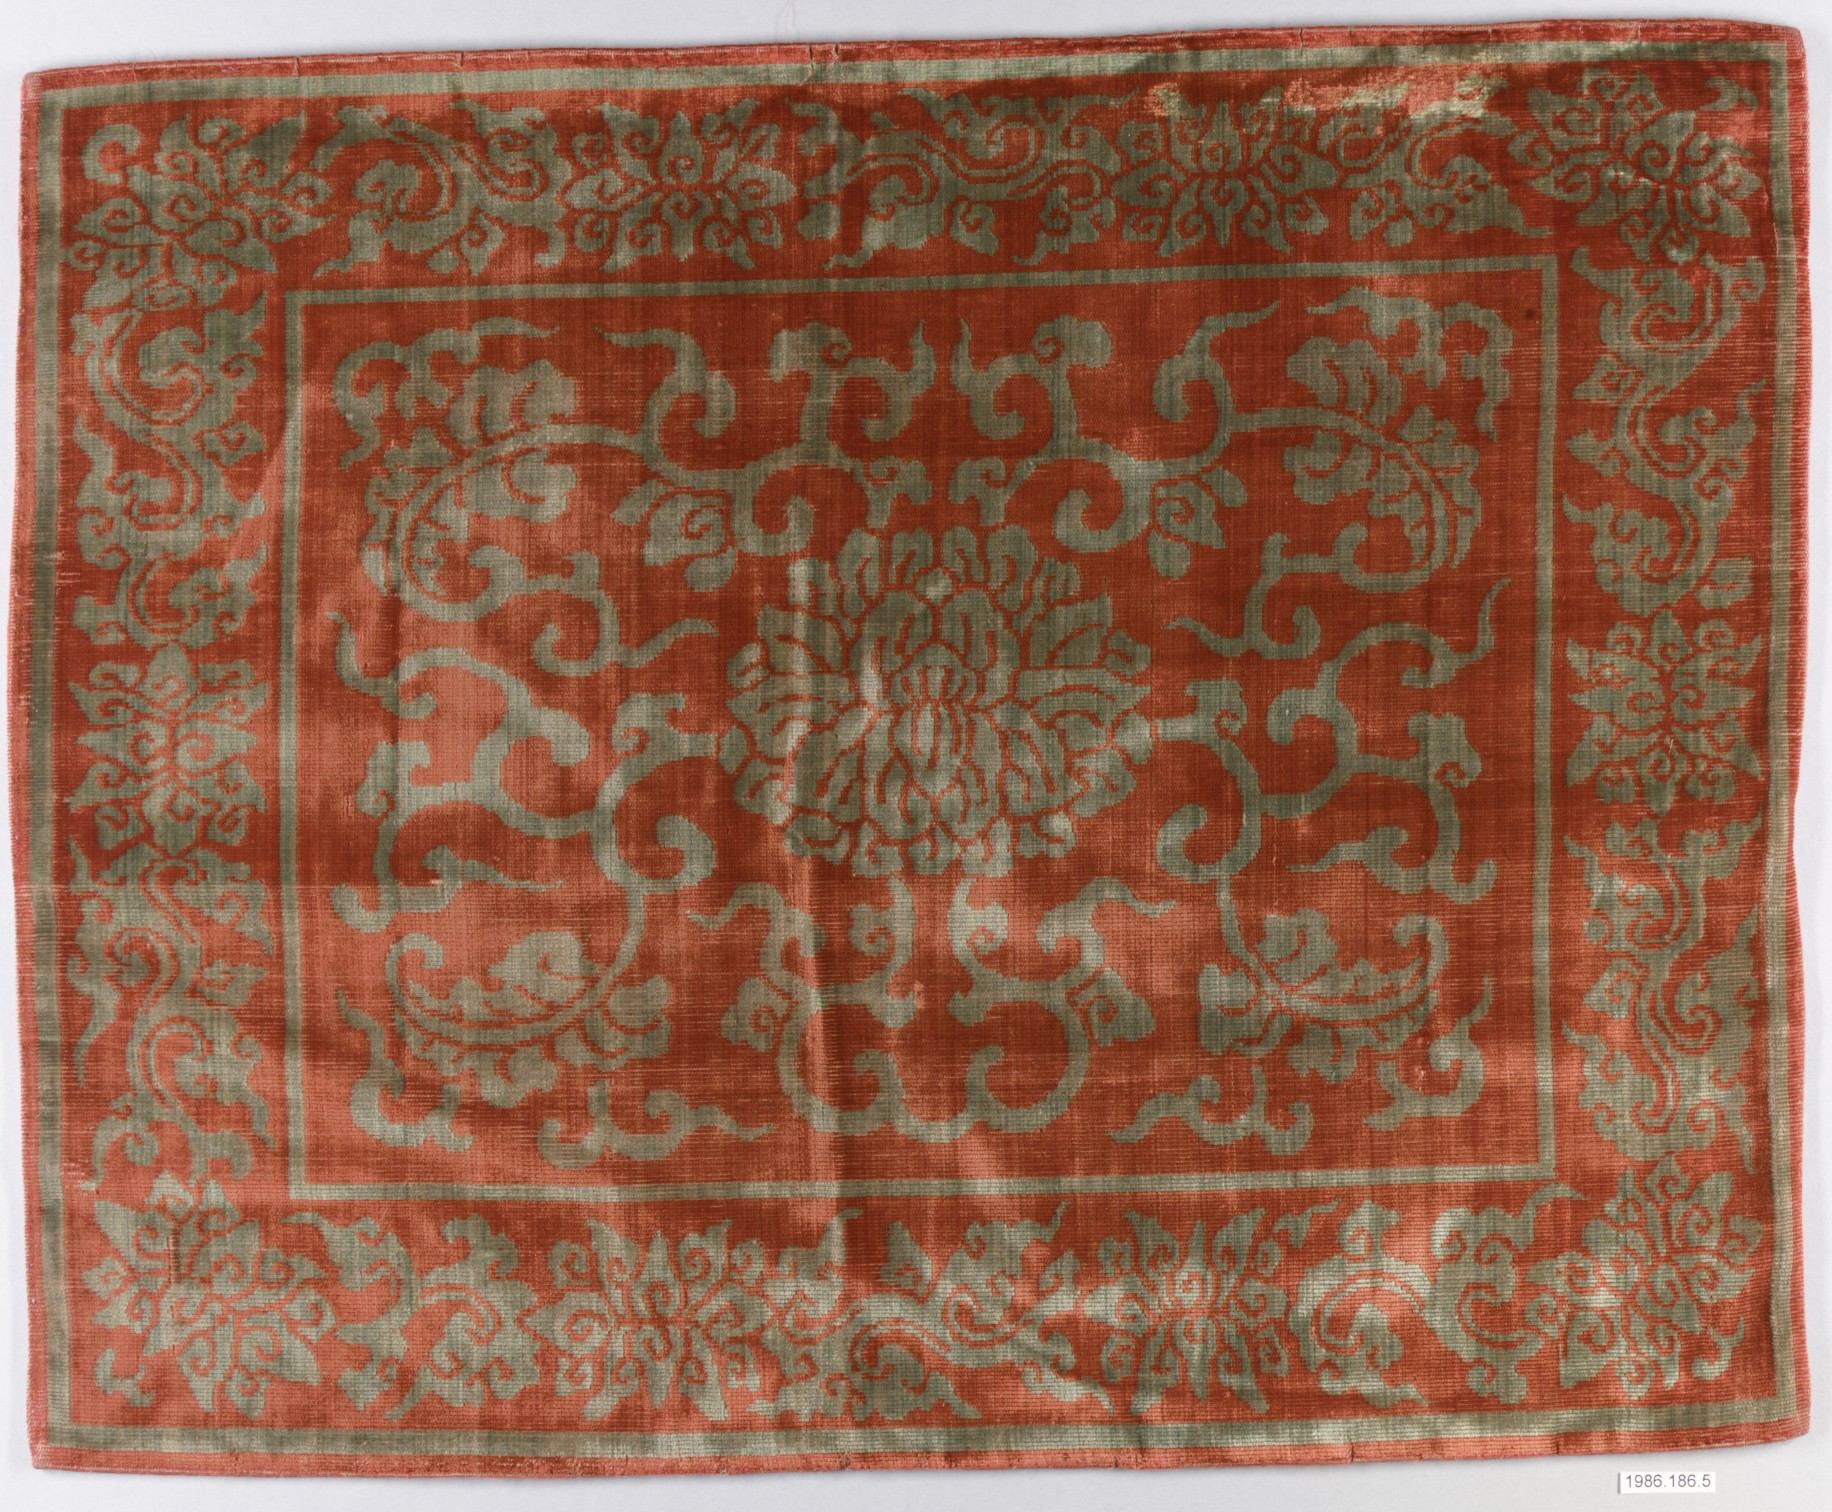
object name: seat cushion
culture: chinese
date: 1644-1911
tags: flowers